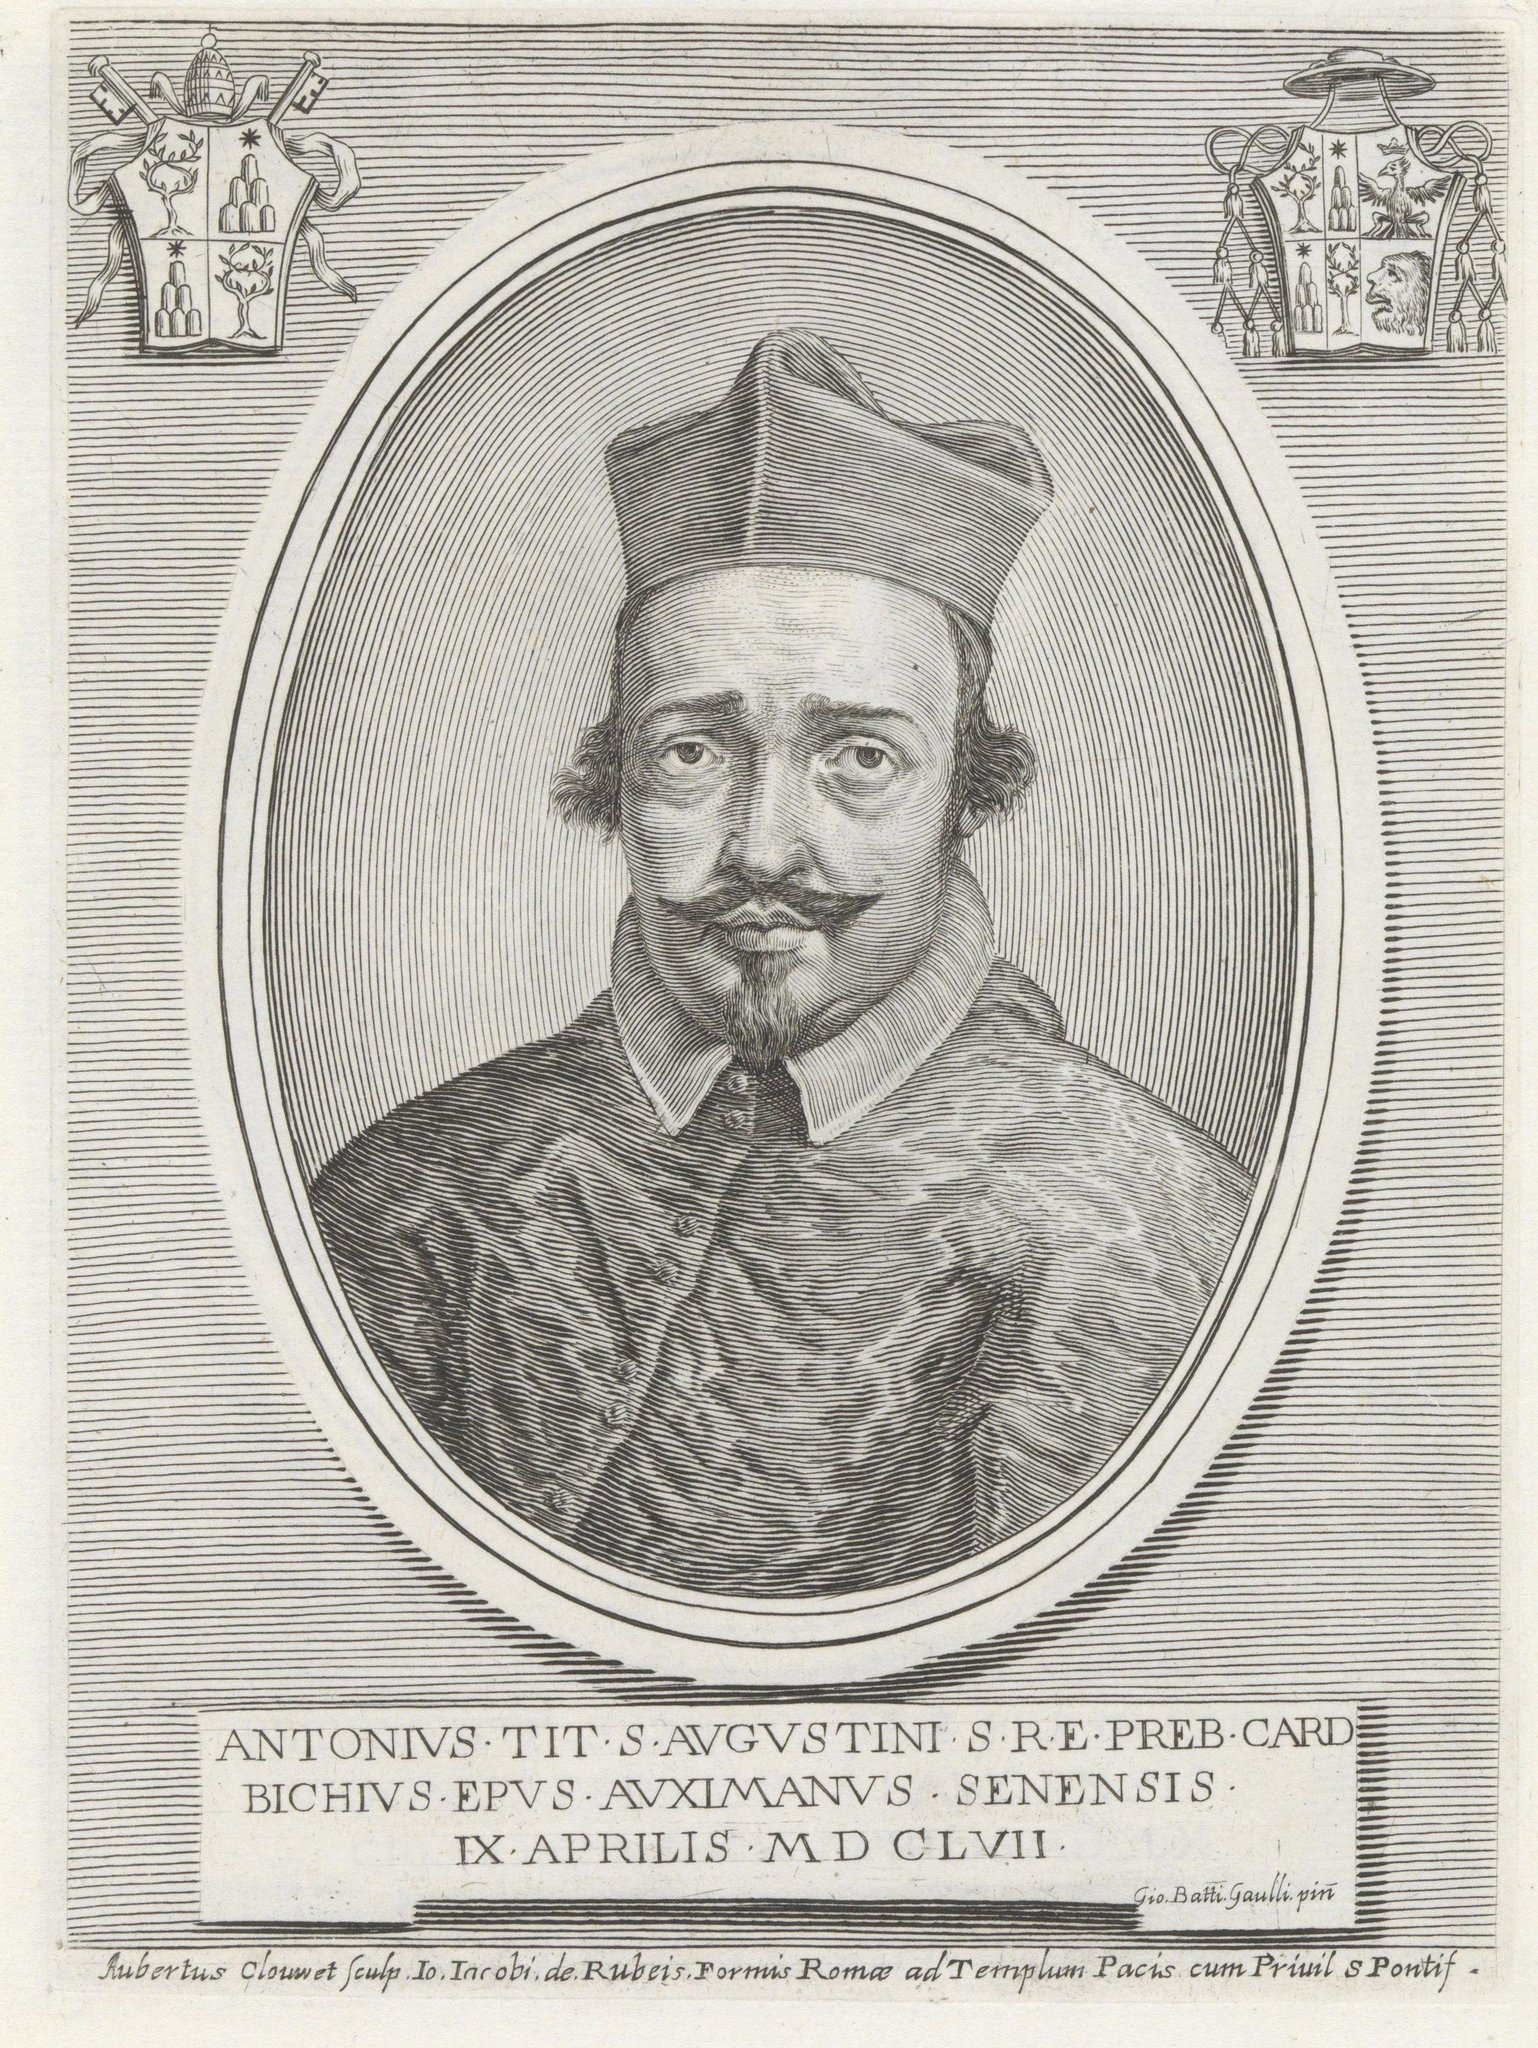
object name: album leaf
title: Portret van kardinaal Antonio Bichi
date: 1658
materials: paper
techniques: engraving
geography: rome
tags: italy, cardinal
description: Portret van kardinaal Antonio Bichi. Linksboven het wapen van paus Alexander VII en rechtsboven het wapen van de kardinaal. Onderaan een onderschrift in het Latijn. De prent maakt deel uit van een album.